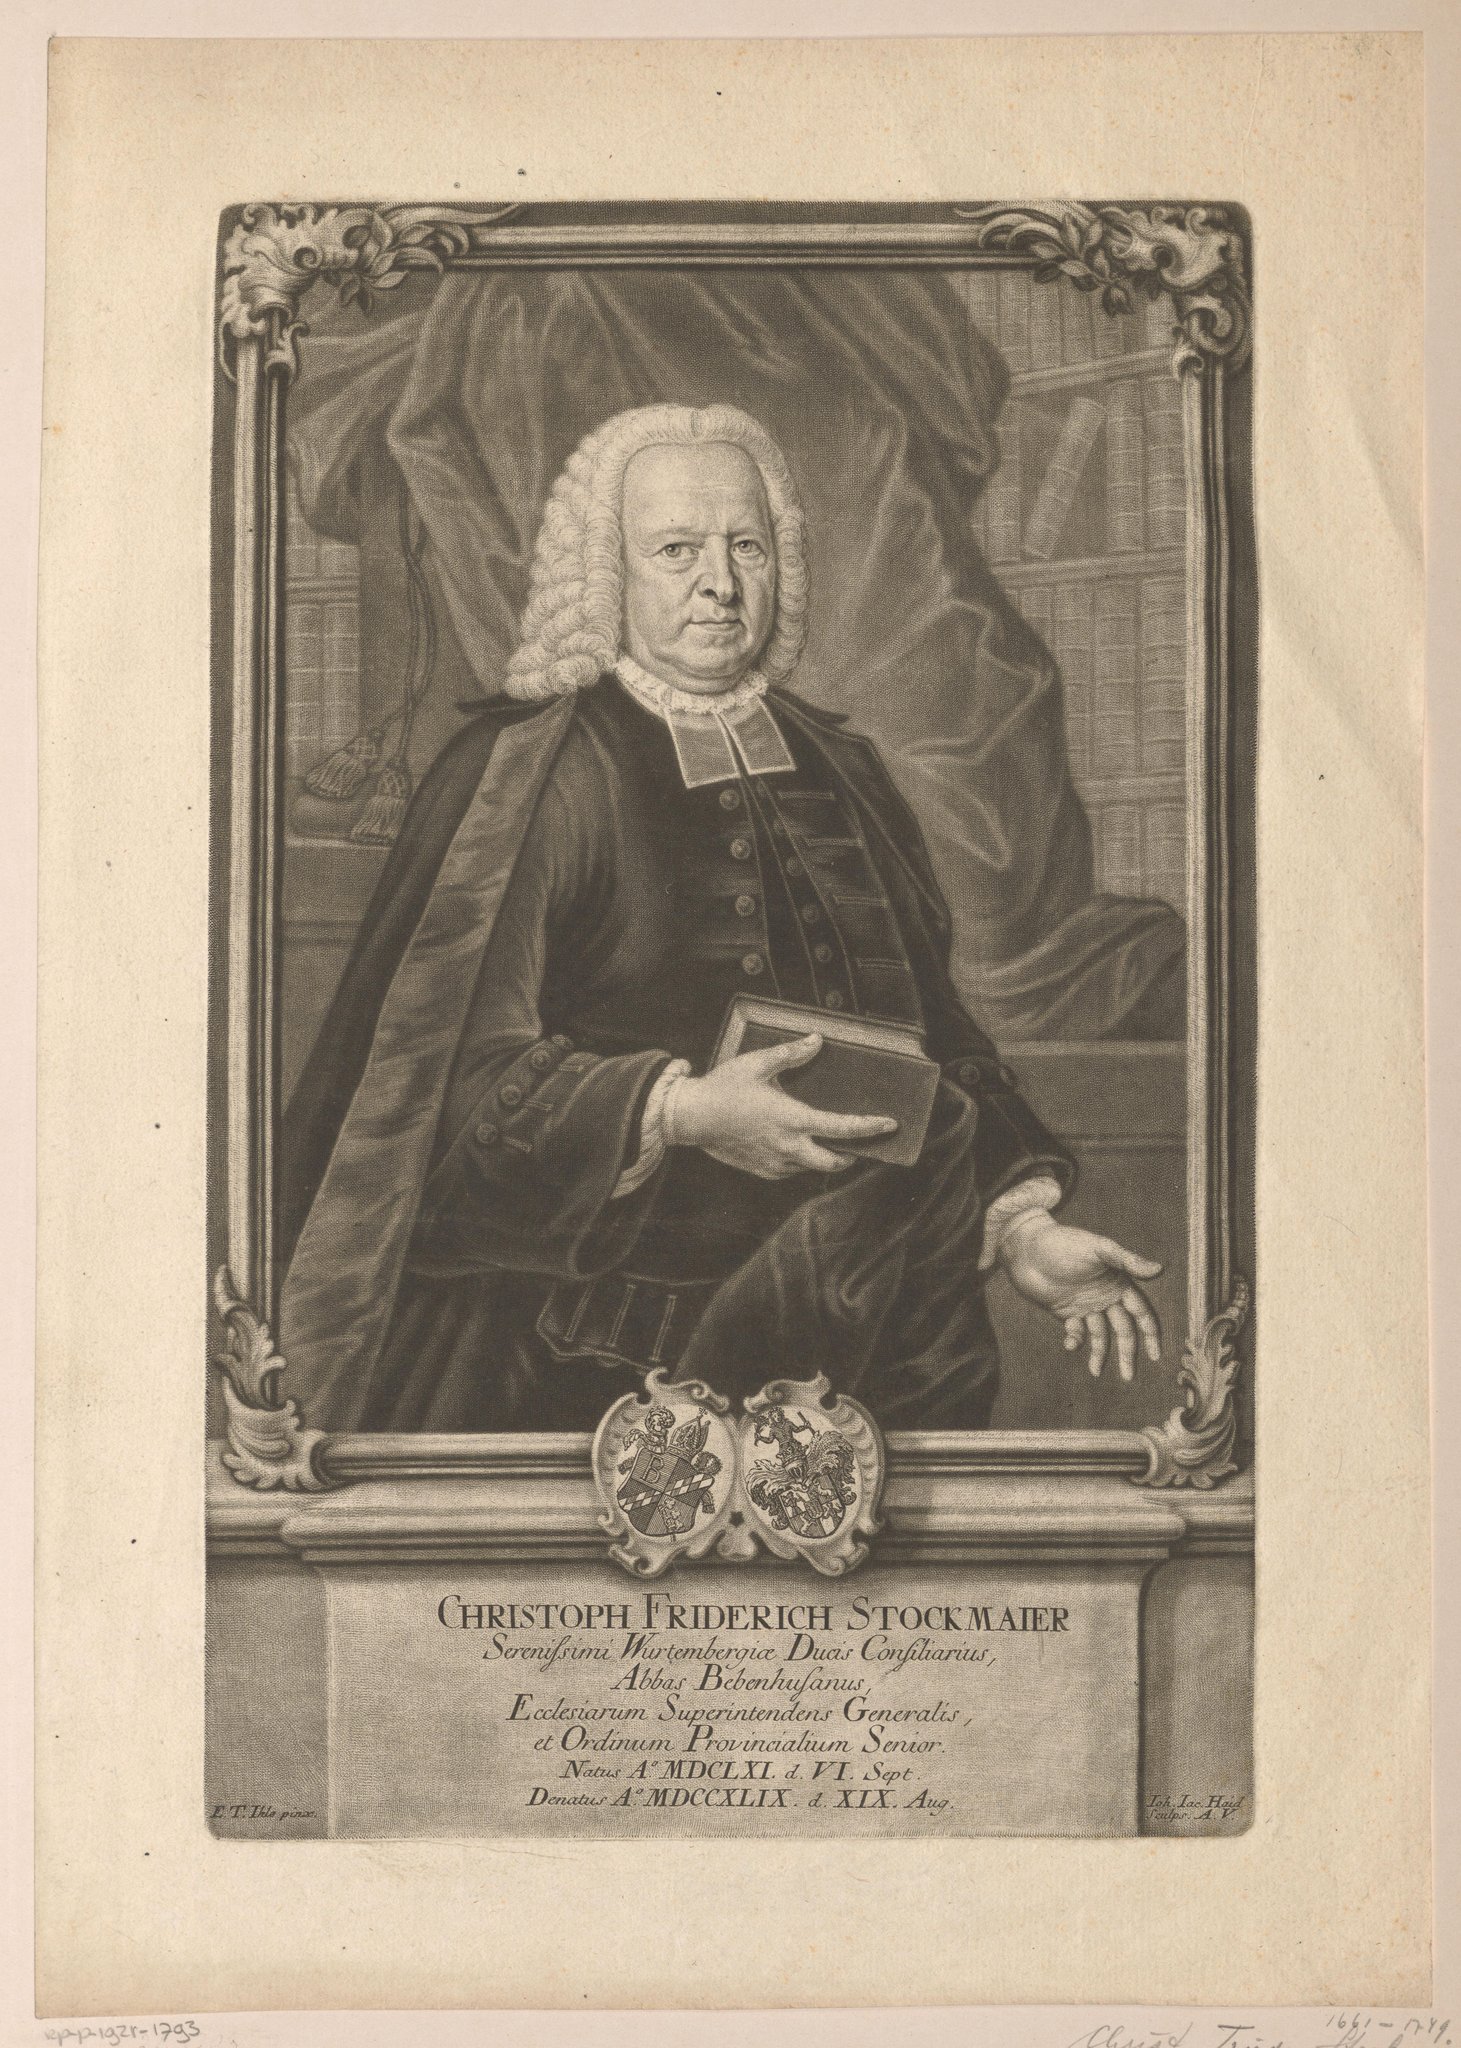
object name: print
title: Portret van Christoph Friedrich Stockmayer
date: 1749-1767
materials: paper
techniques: etching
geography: augsburg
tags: historical persons, priests ~ hierarchy of priests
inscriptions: collector's mark: Lugt 2233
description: Met zesregelig onderschrift in het Latijn.